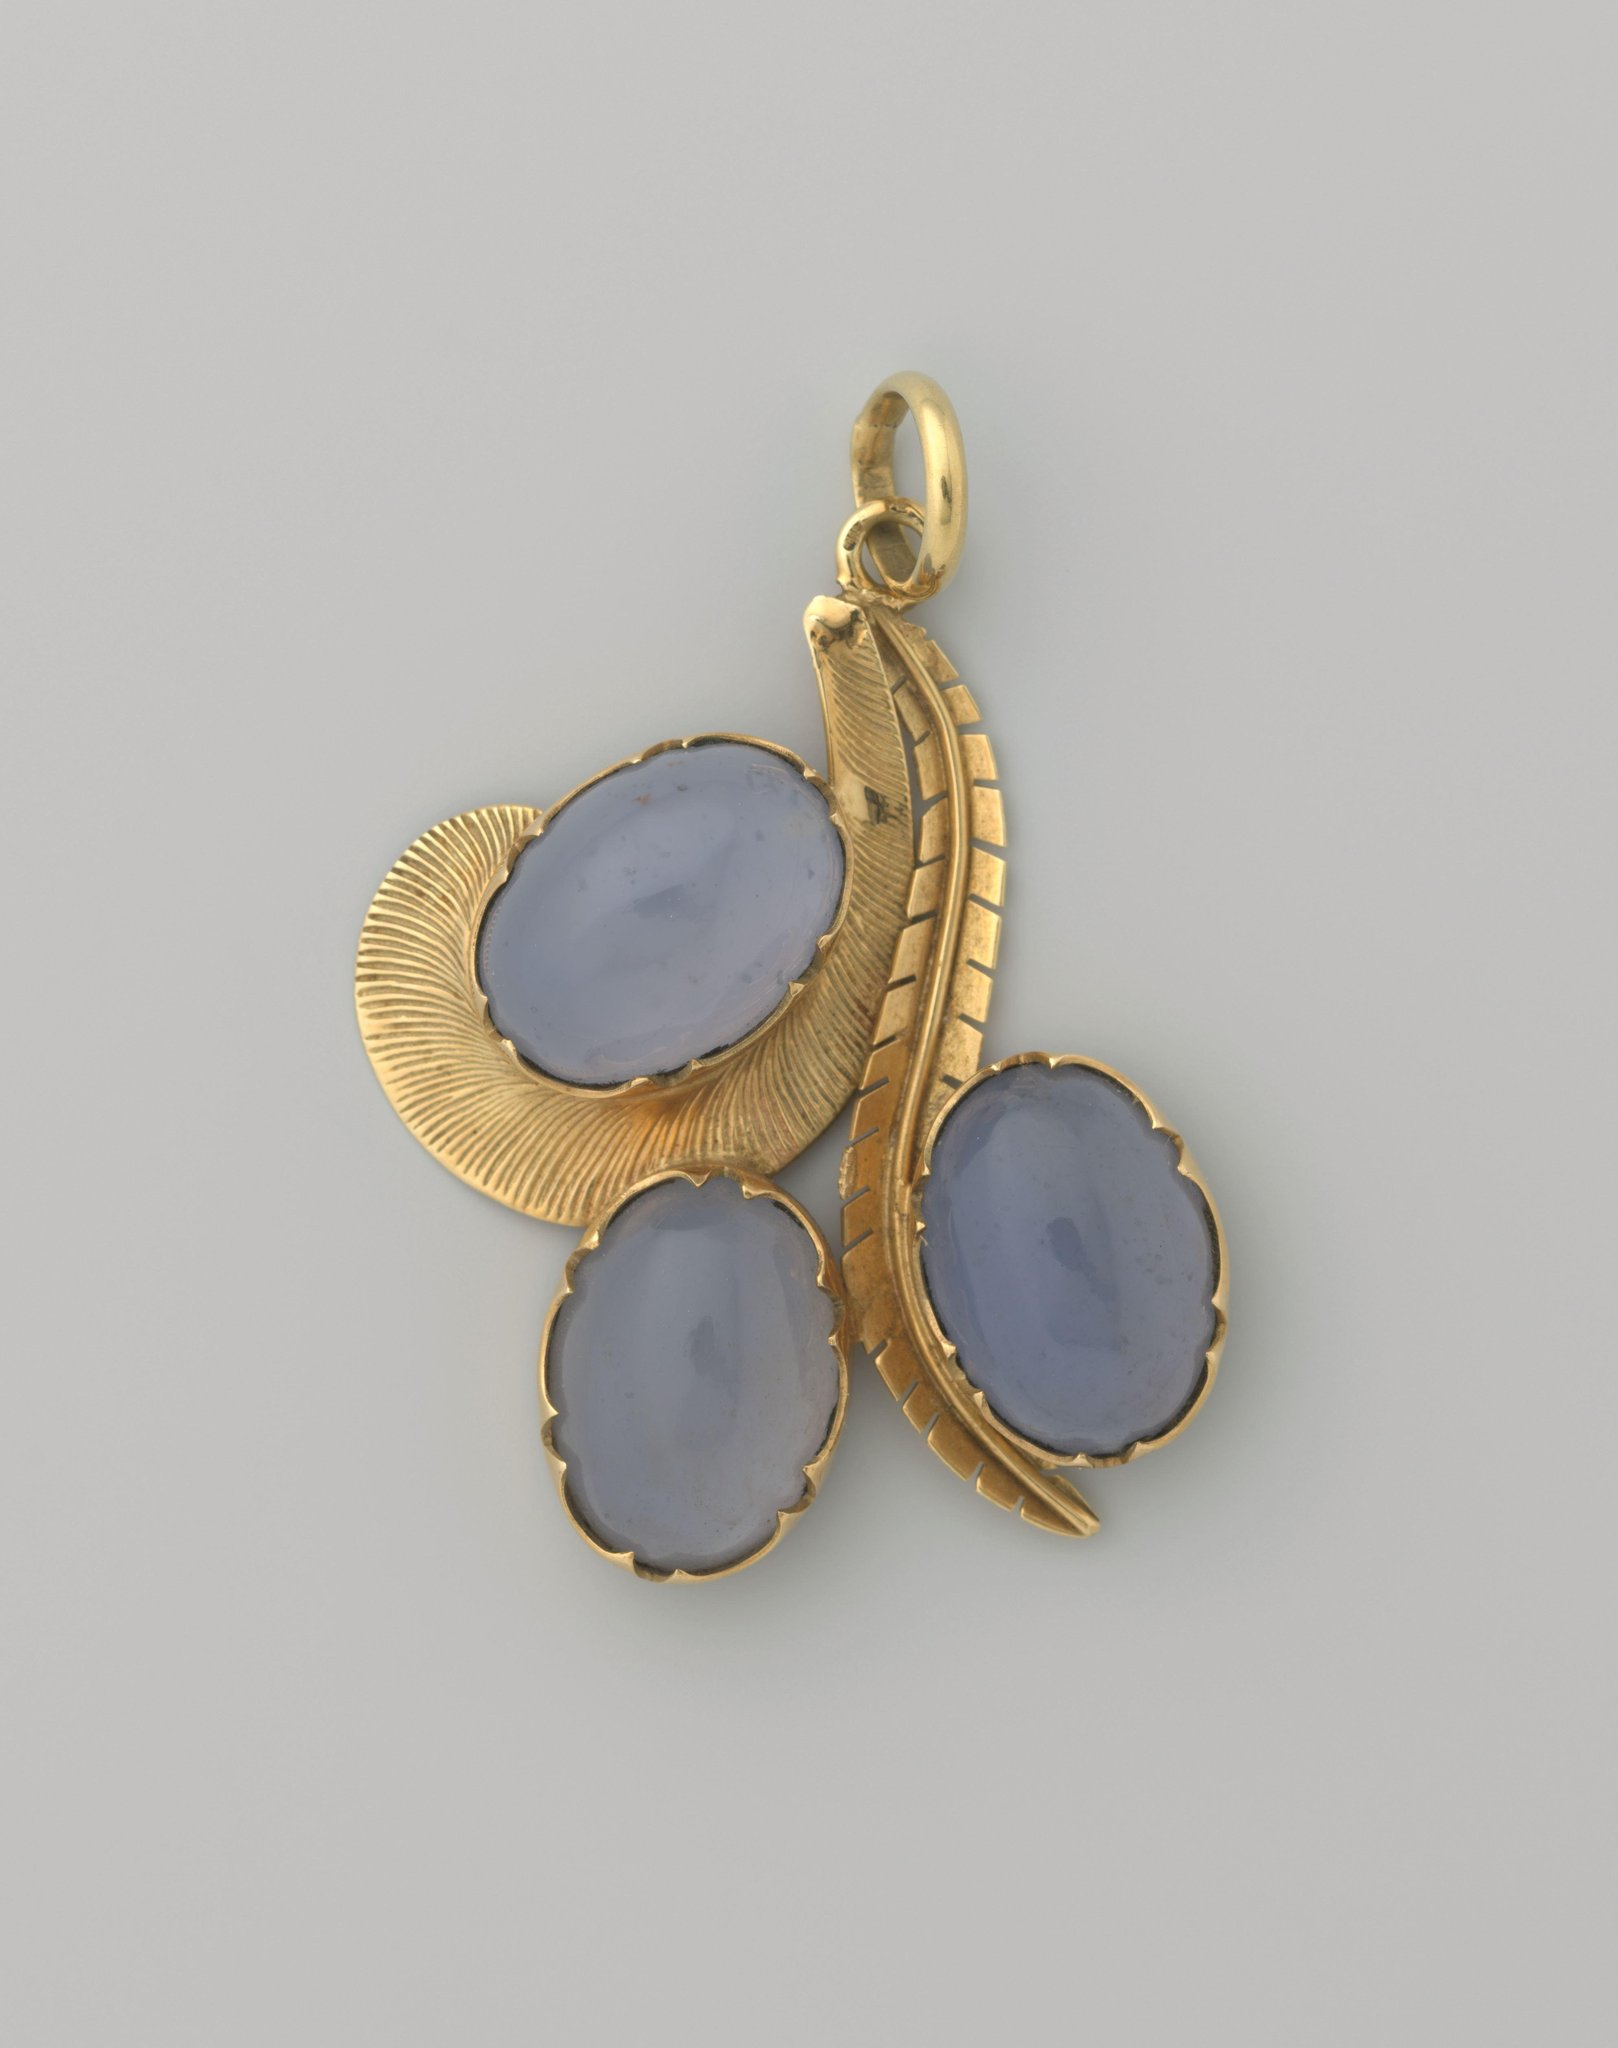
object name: pendant jewelry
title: Hanger van goud met drie blauwe ovale cabochon geslepen chalcedonen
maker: Anonymous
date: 1900-1999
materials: stone, gold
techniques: grinding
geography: netherlands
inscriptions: alloy mark, maker's mark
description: Hanger van goud met drie blauwe ovale cabochon geslepen chalcedonen voorzien van een draadoog.